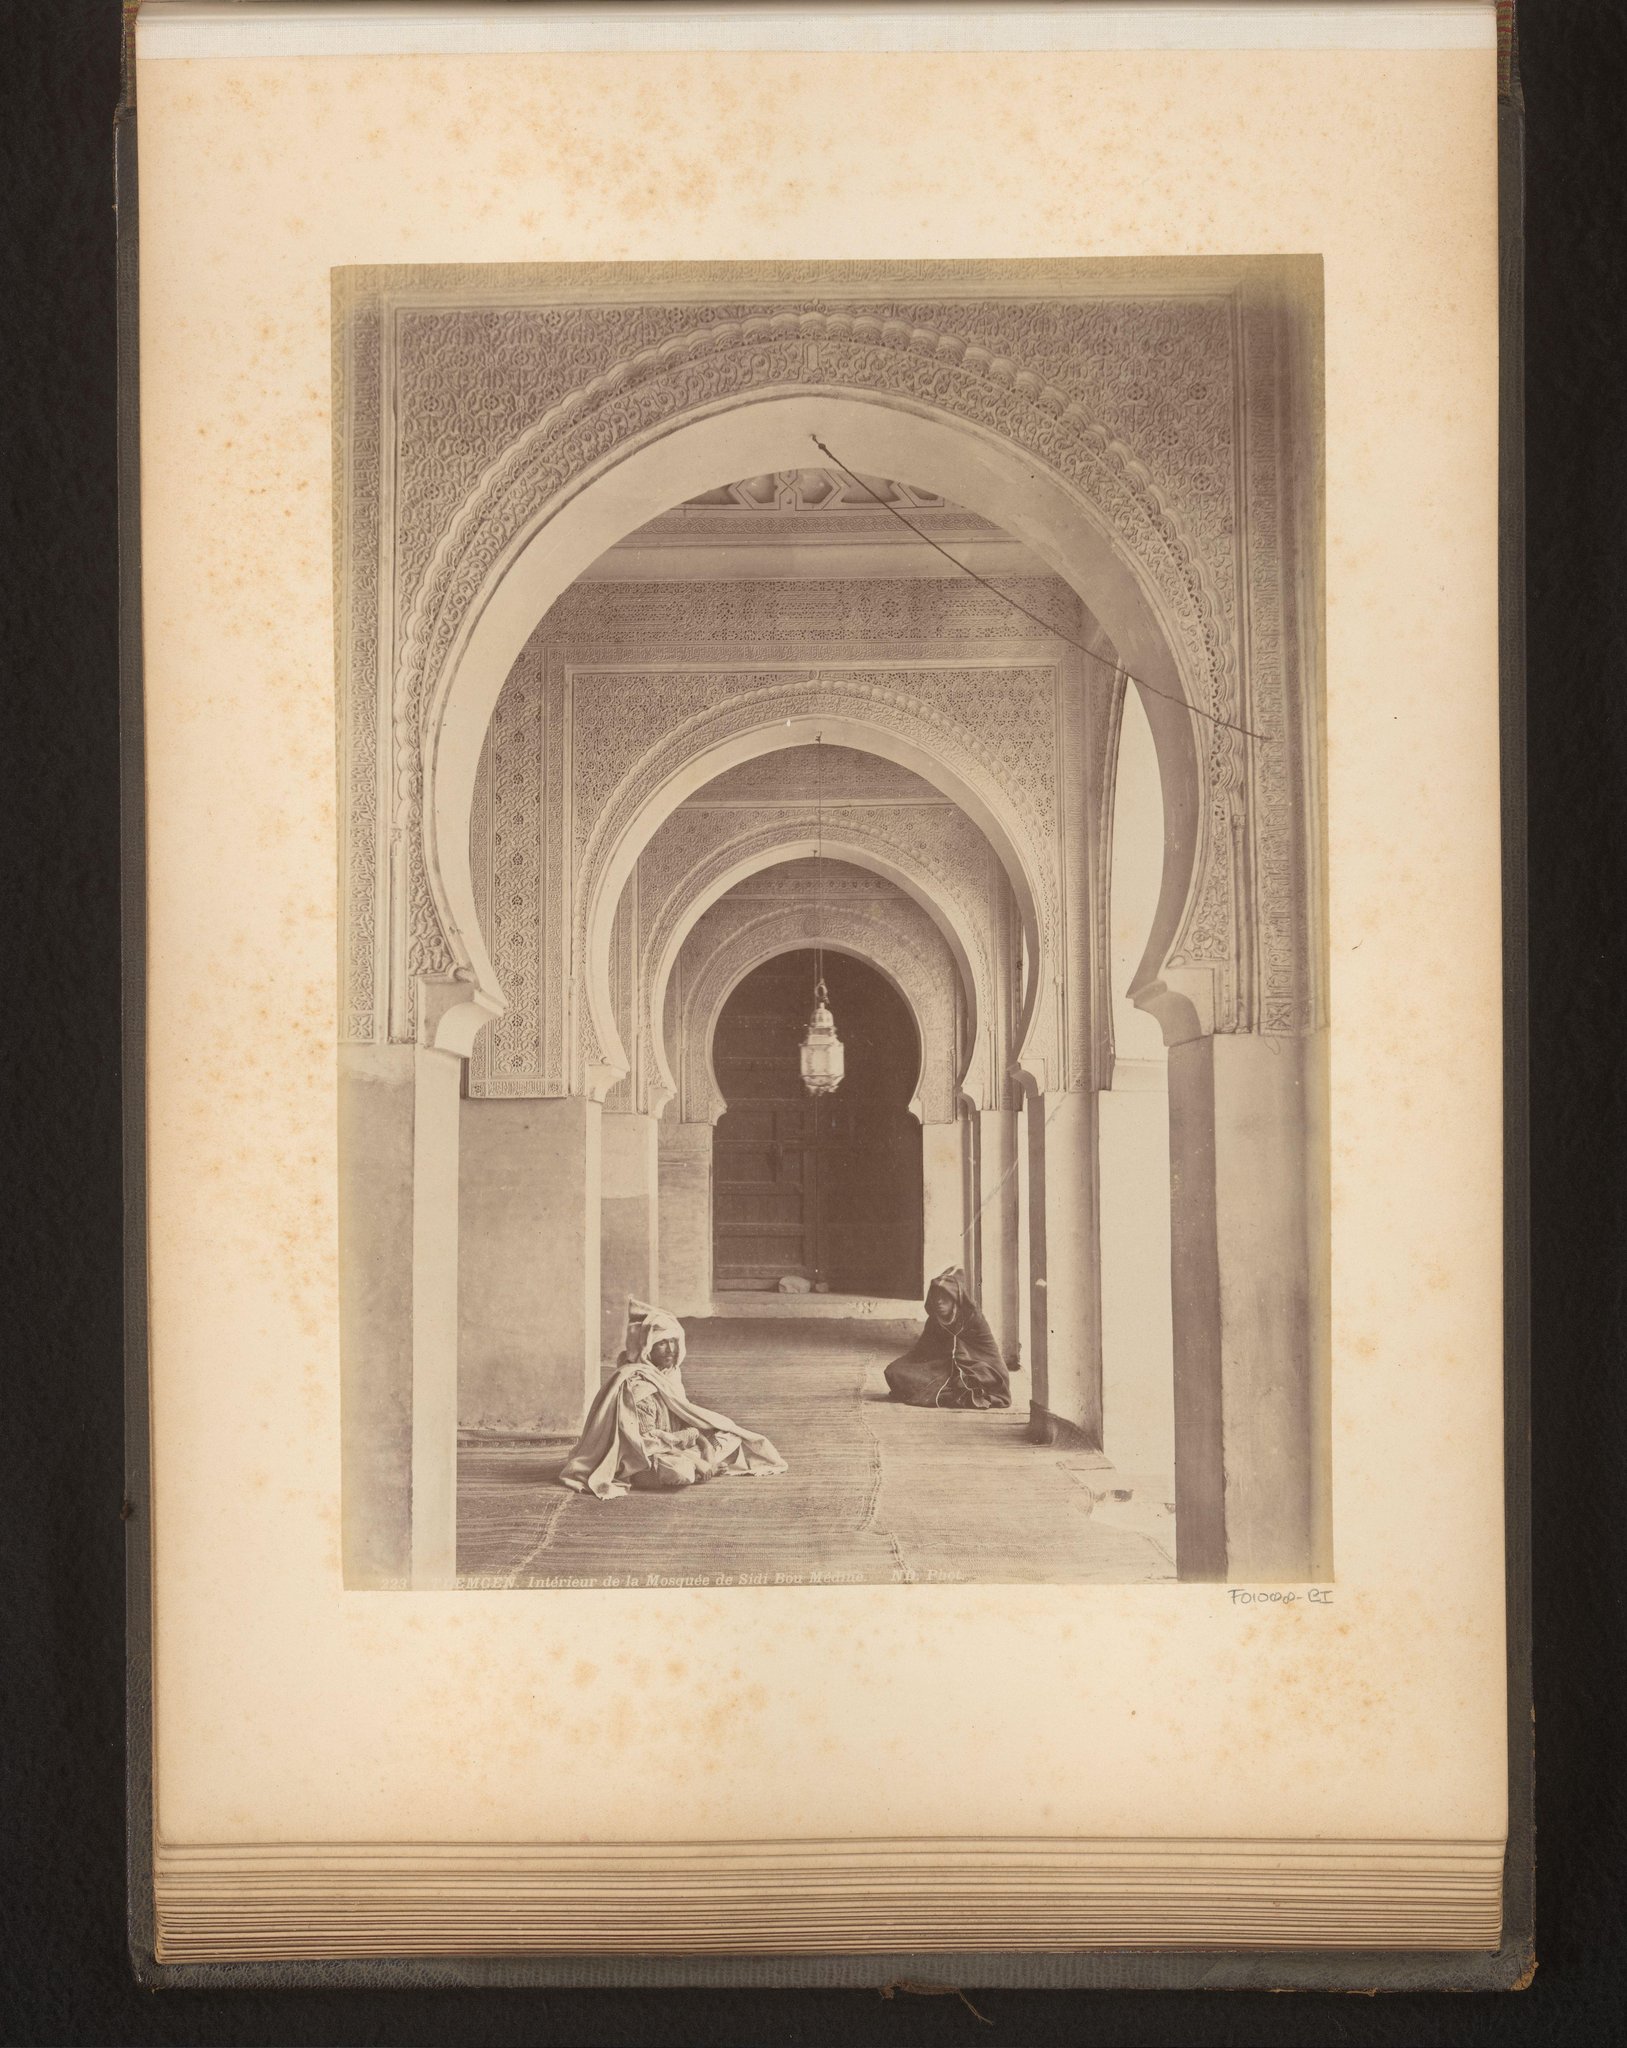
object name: photograph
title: Tlemcen. Interieur de la Mosquee de Sidi Bou Medine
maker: étienne neurdein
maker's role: publisher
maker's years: 1832-1918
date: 1880-1900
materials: photographic support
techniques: albumen print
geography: tlemcen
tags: colonnade, temple, shrine ~ islam, mohammedanism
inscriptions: number: ‘223’